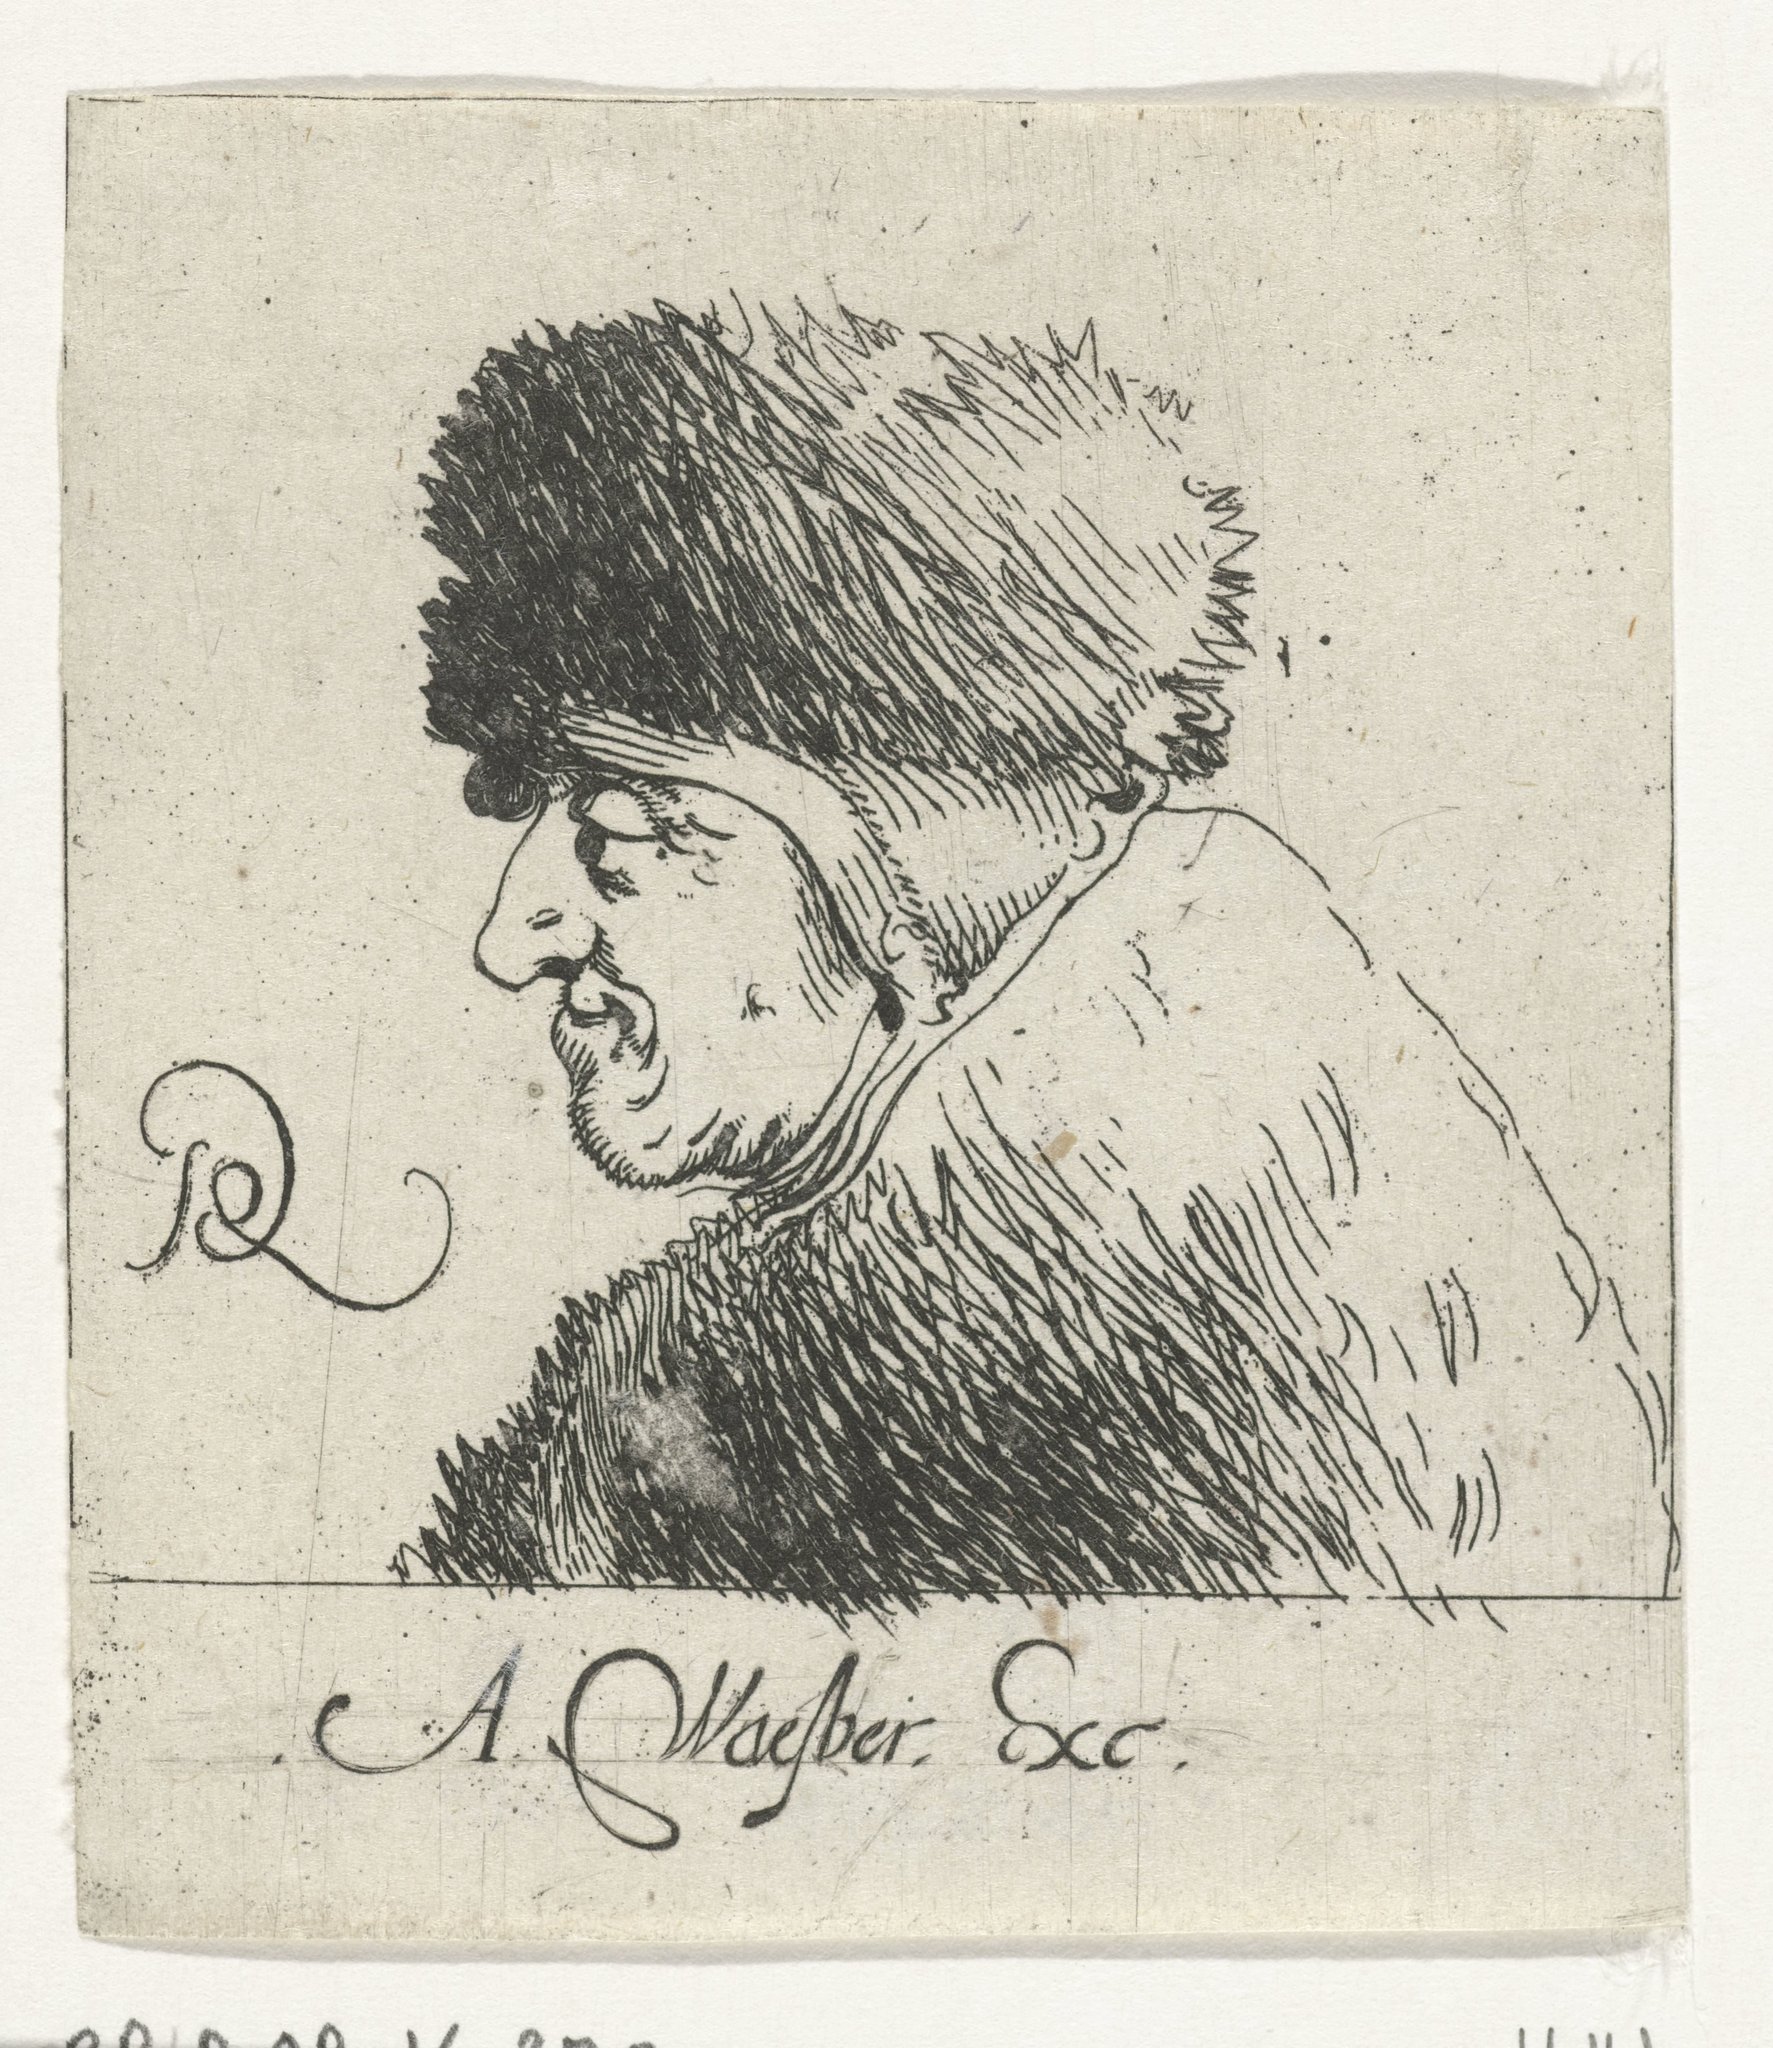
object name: print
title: Portret van een oude vrouw met een muts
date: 1615-1647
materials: paper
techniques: etching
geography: netherlands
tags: head-gear: cap (+ men's clothes), old woman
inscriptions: collector's mark: Lugt 240